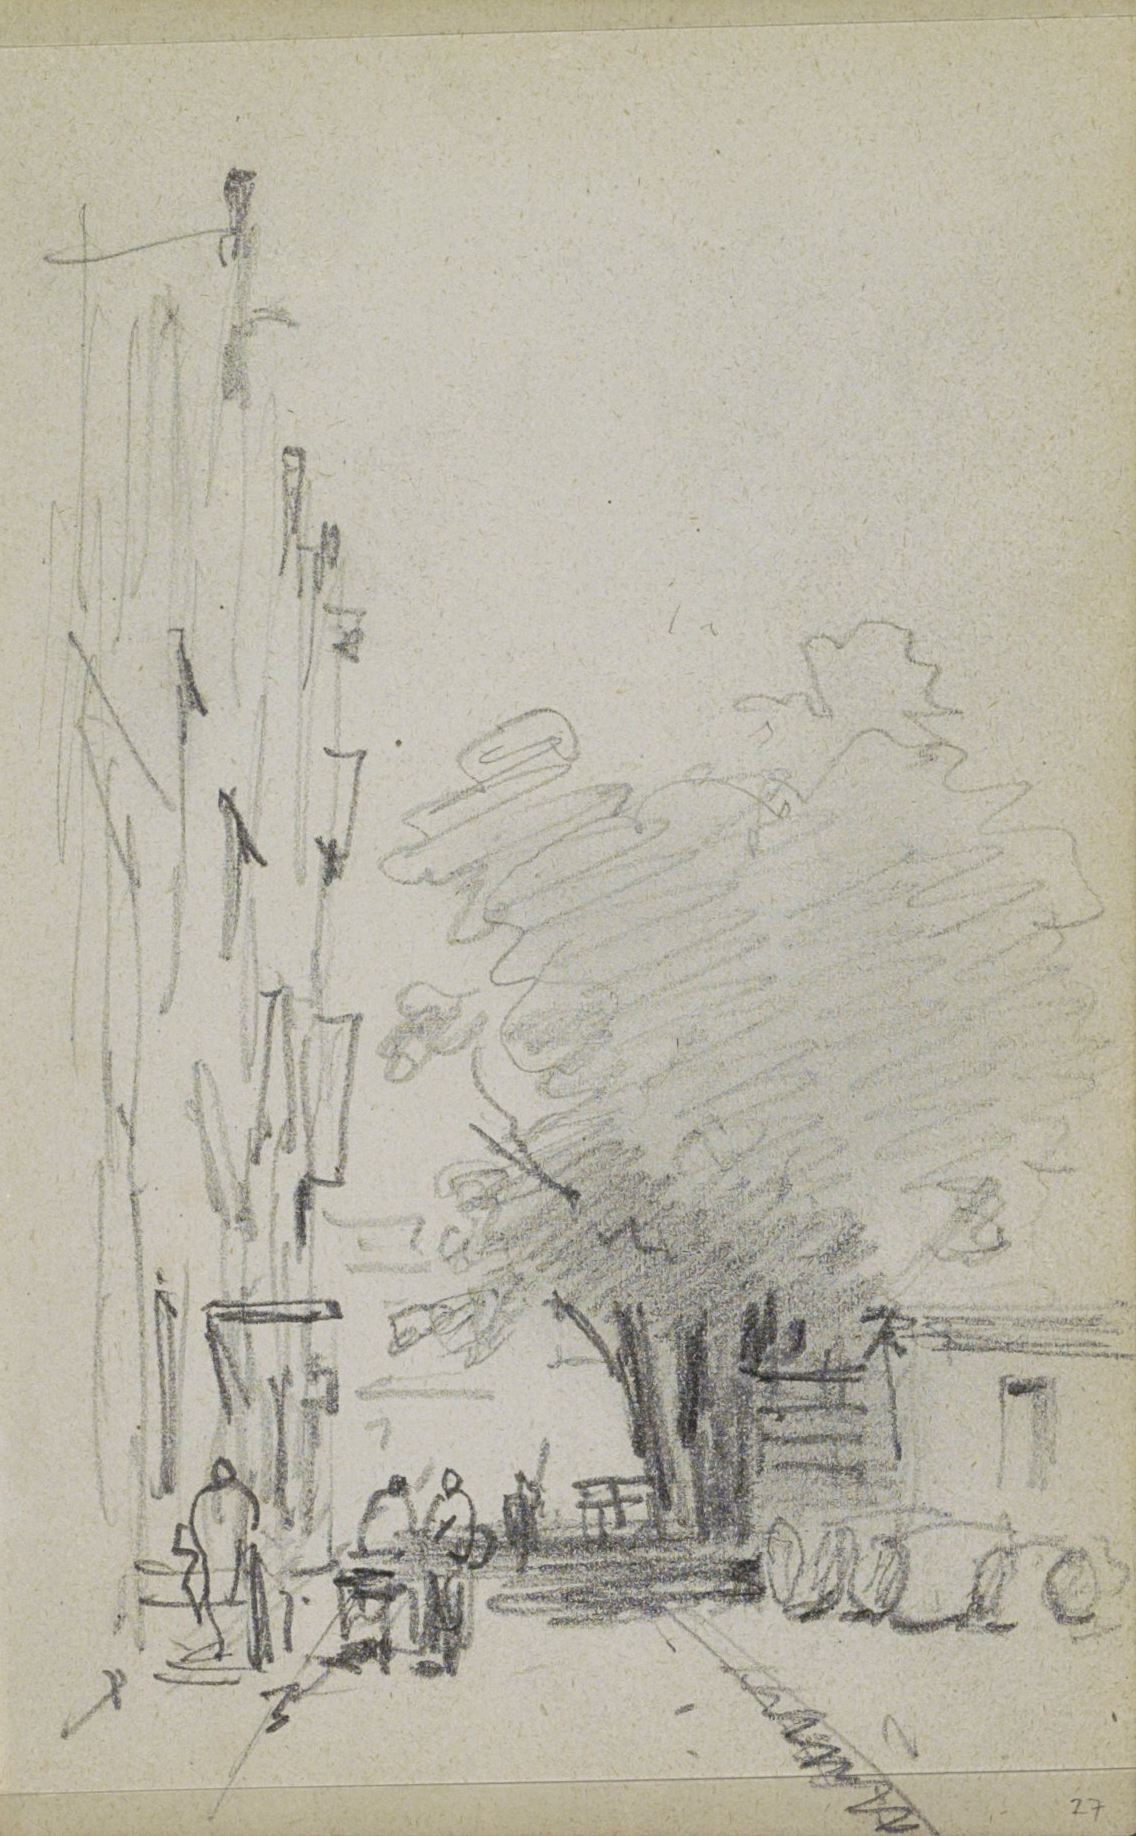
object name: sketchbook leaf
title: Gezicht op een straat of plein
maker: adrianus eversen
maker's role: draughtsman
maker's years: 1818-1897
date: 1828-1897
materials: paper, pencil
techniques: stumping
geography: netherlands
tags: square, place, circus, etc., urban housing, street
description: Gezicht op een straat of plein. Links figuren voor een gebouw. Rechts bomen. Vooraan mogelijk water. Blad 27 recto uit een schetsboek met 58 bladen.